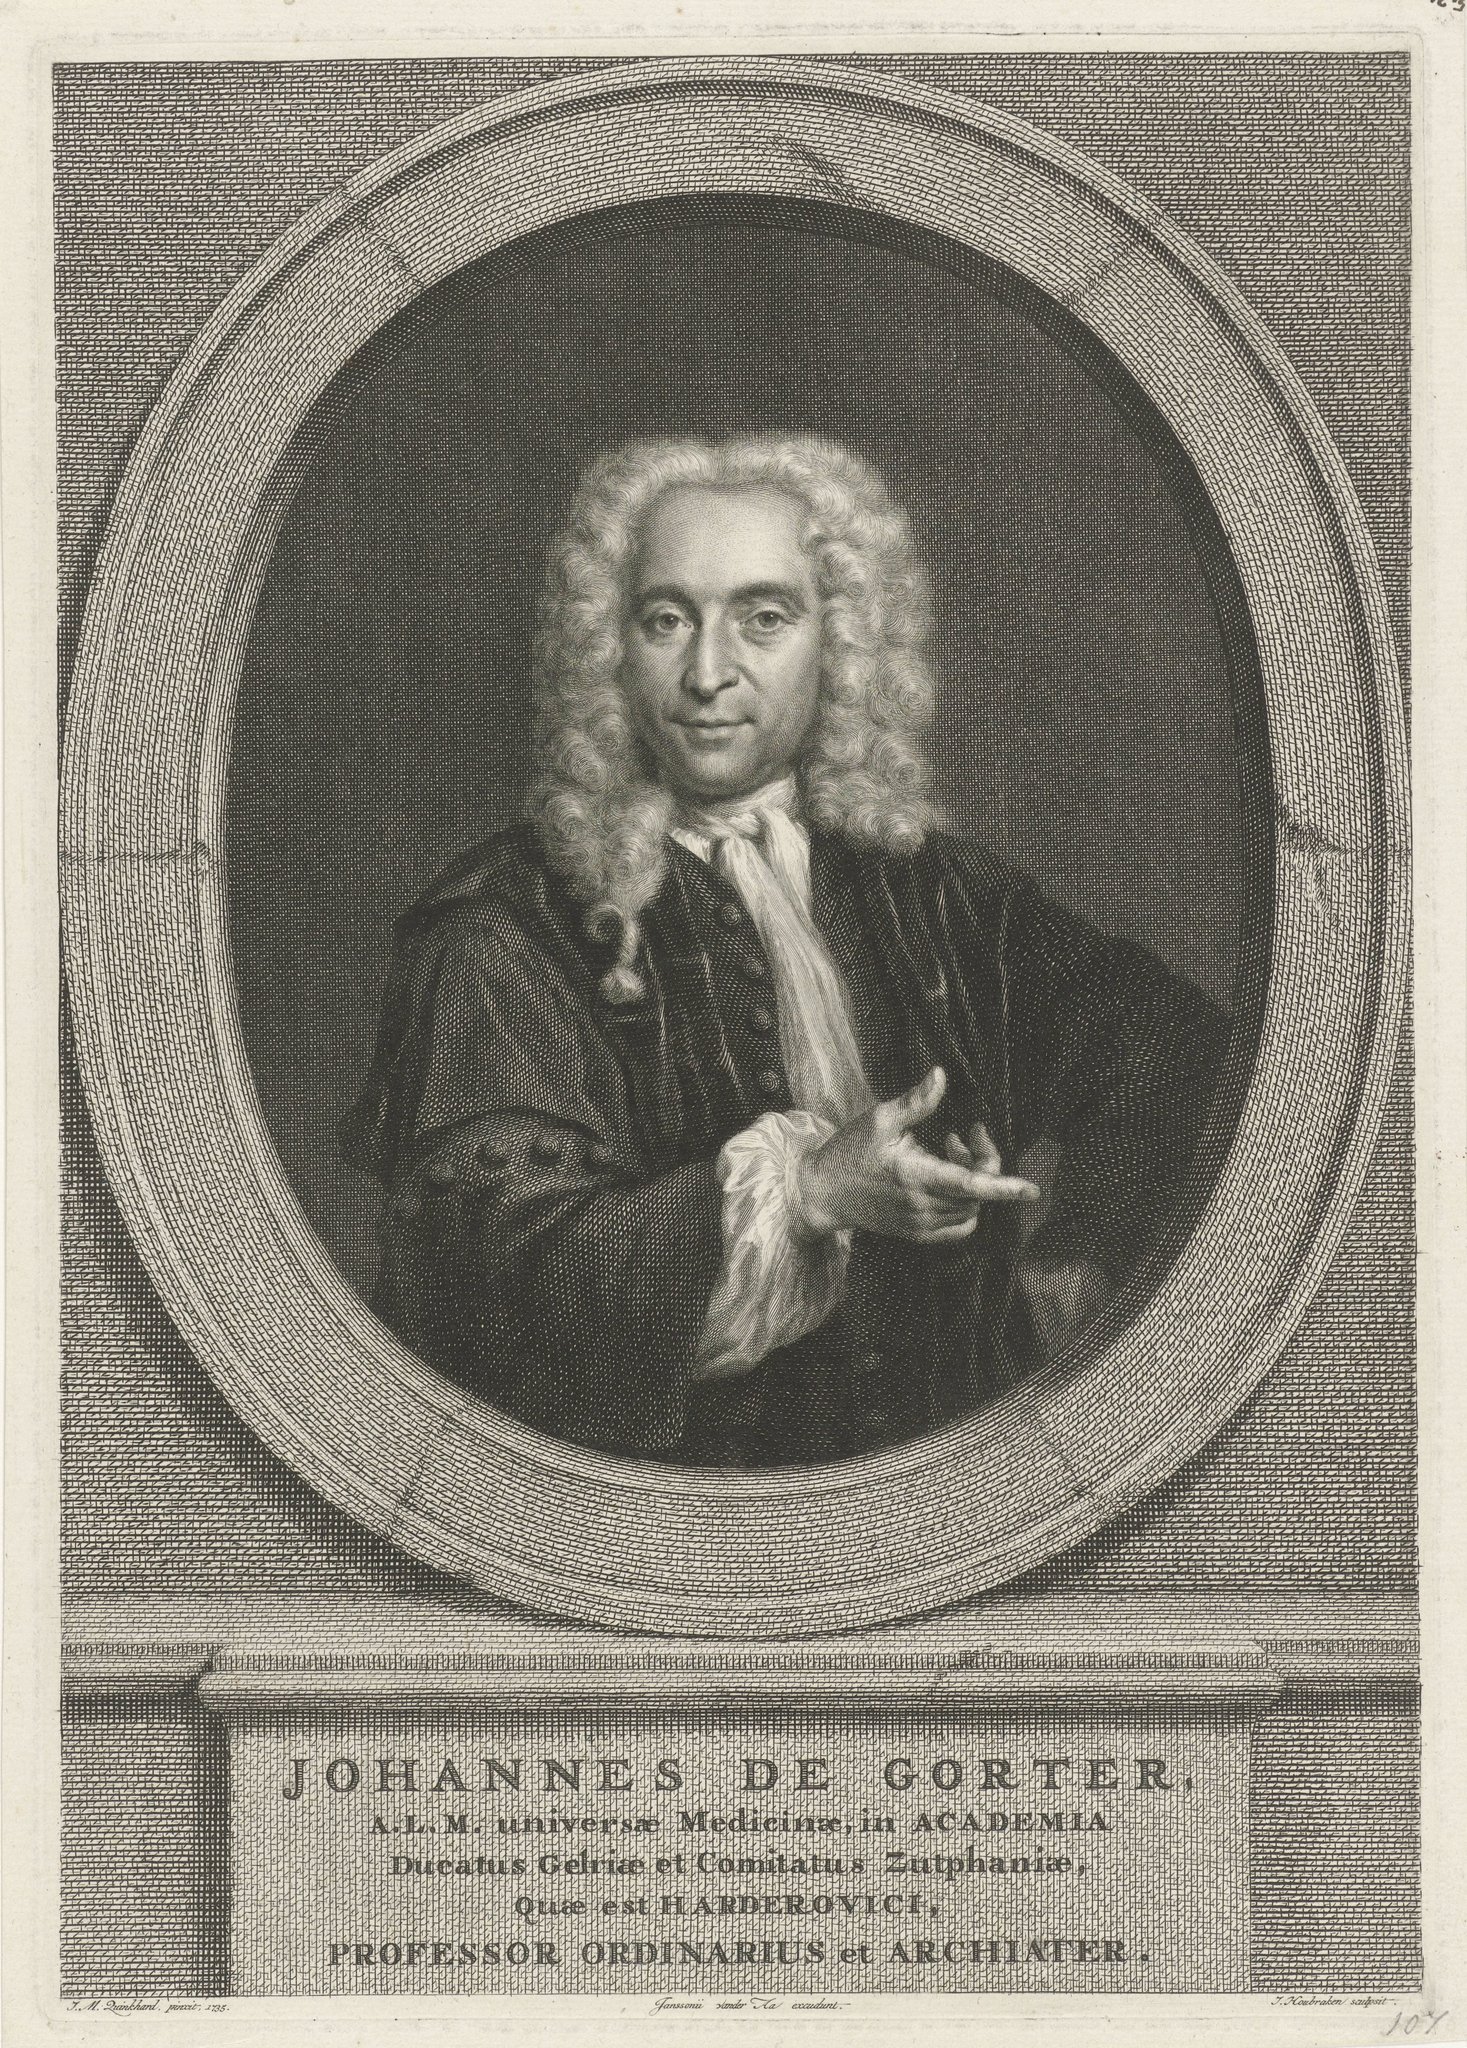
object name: print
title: Portret van Johannes de Gorter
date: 1735-1747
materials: paper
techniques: engraving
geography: leiden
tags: botanicus, johannes de gorter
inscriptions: collector's mark: Lugt 240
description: Portret ten halven lijve van Johannes de Gorter in een ovaal. Het portret rust op een richel waarop zijn naam en gegevens in vijf regels in het Latijn.